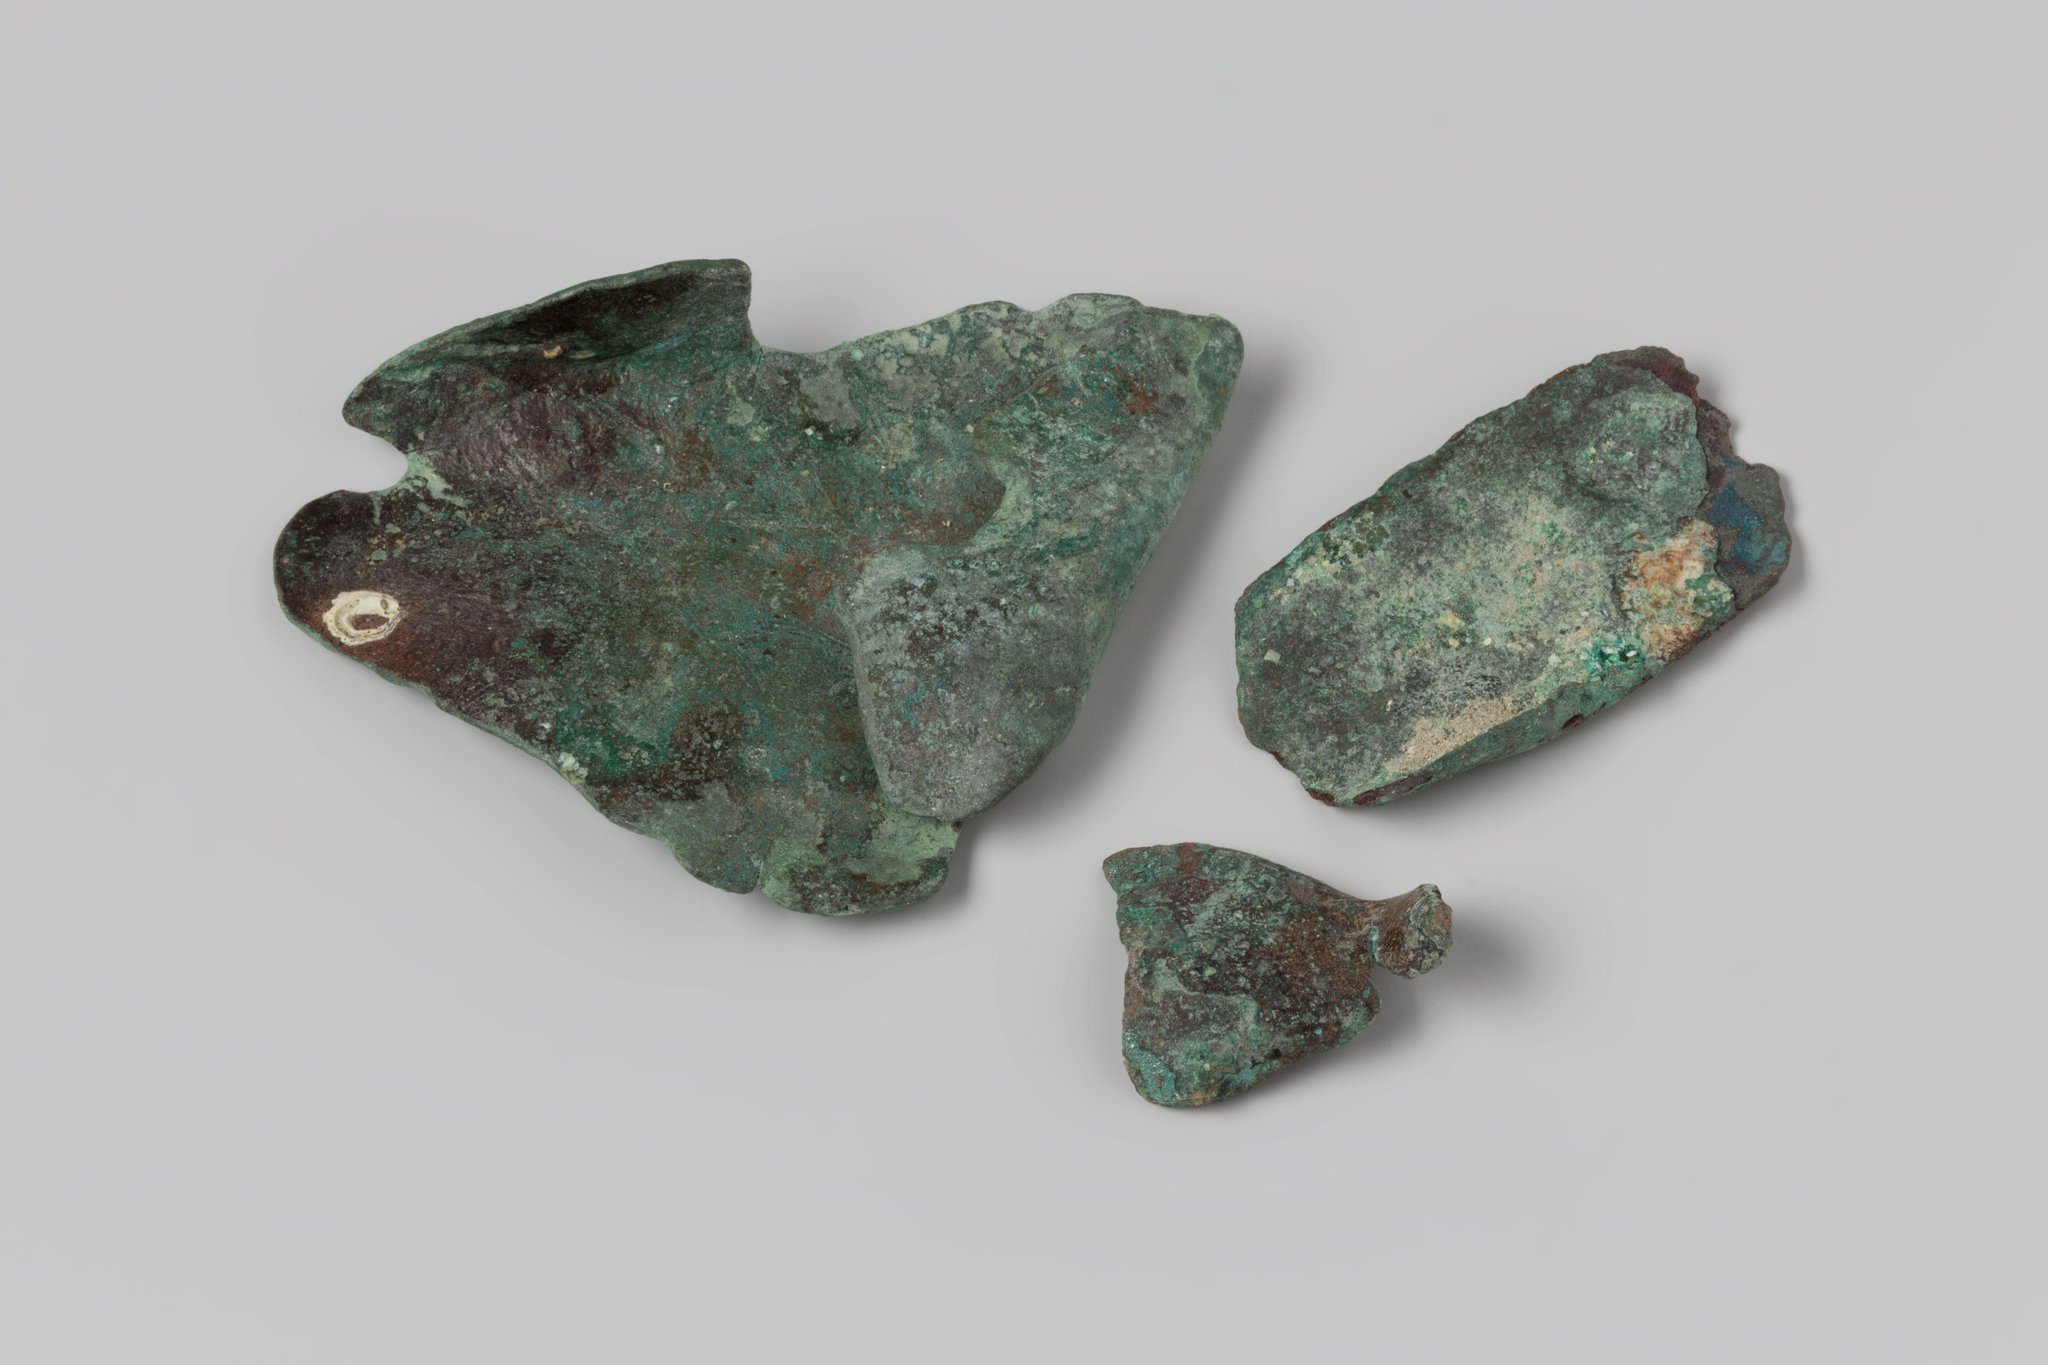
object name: scheepswrakvondst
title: Fragmenten van koper uit het wrak van de Oost-Indiëvaarder Hollandia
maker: Anonymous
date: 1700-1743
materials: copper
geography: netherlands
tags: verenigde oostindische compagnie, hollandia (schip), annet